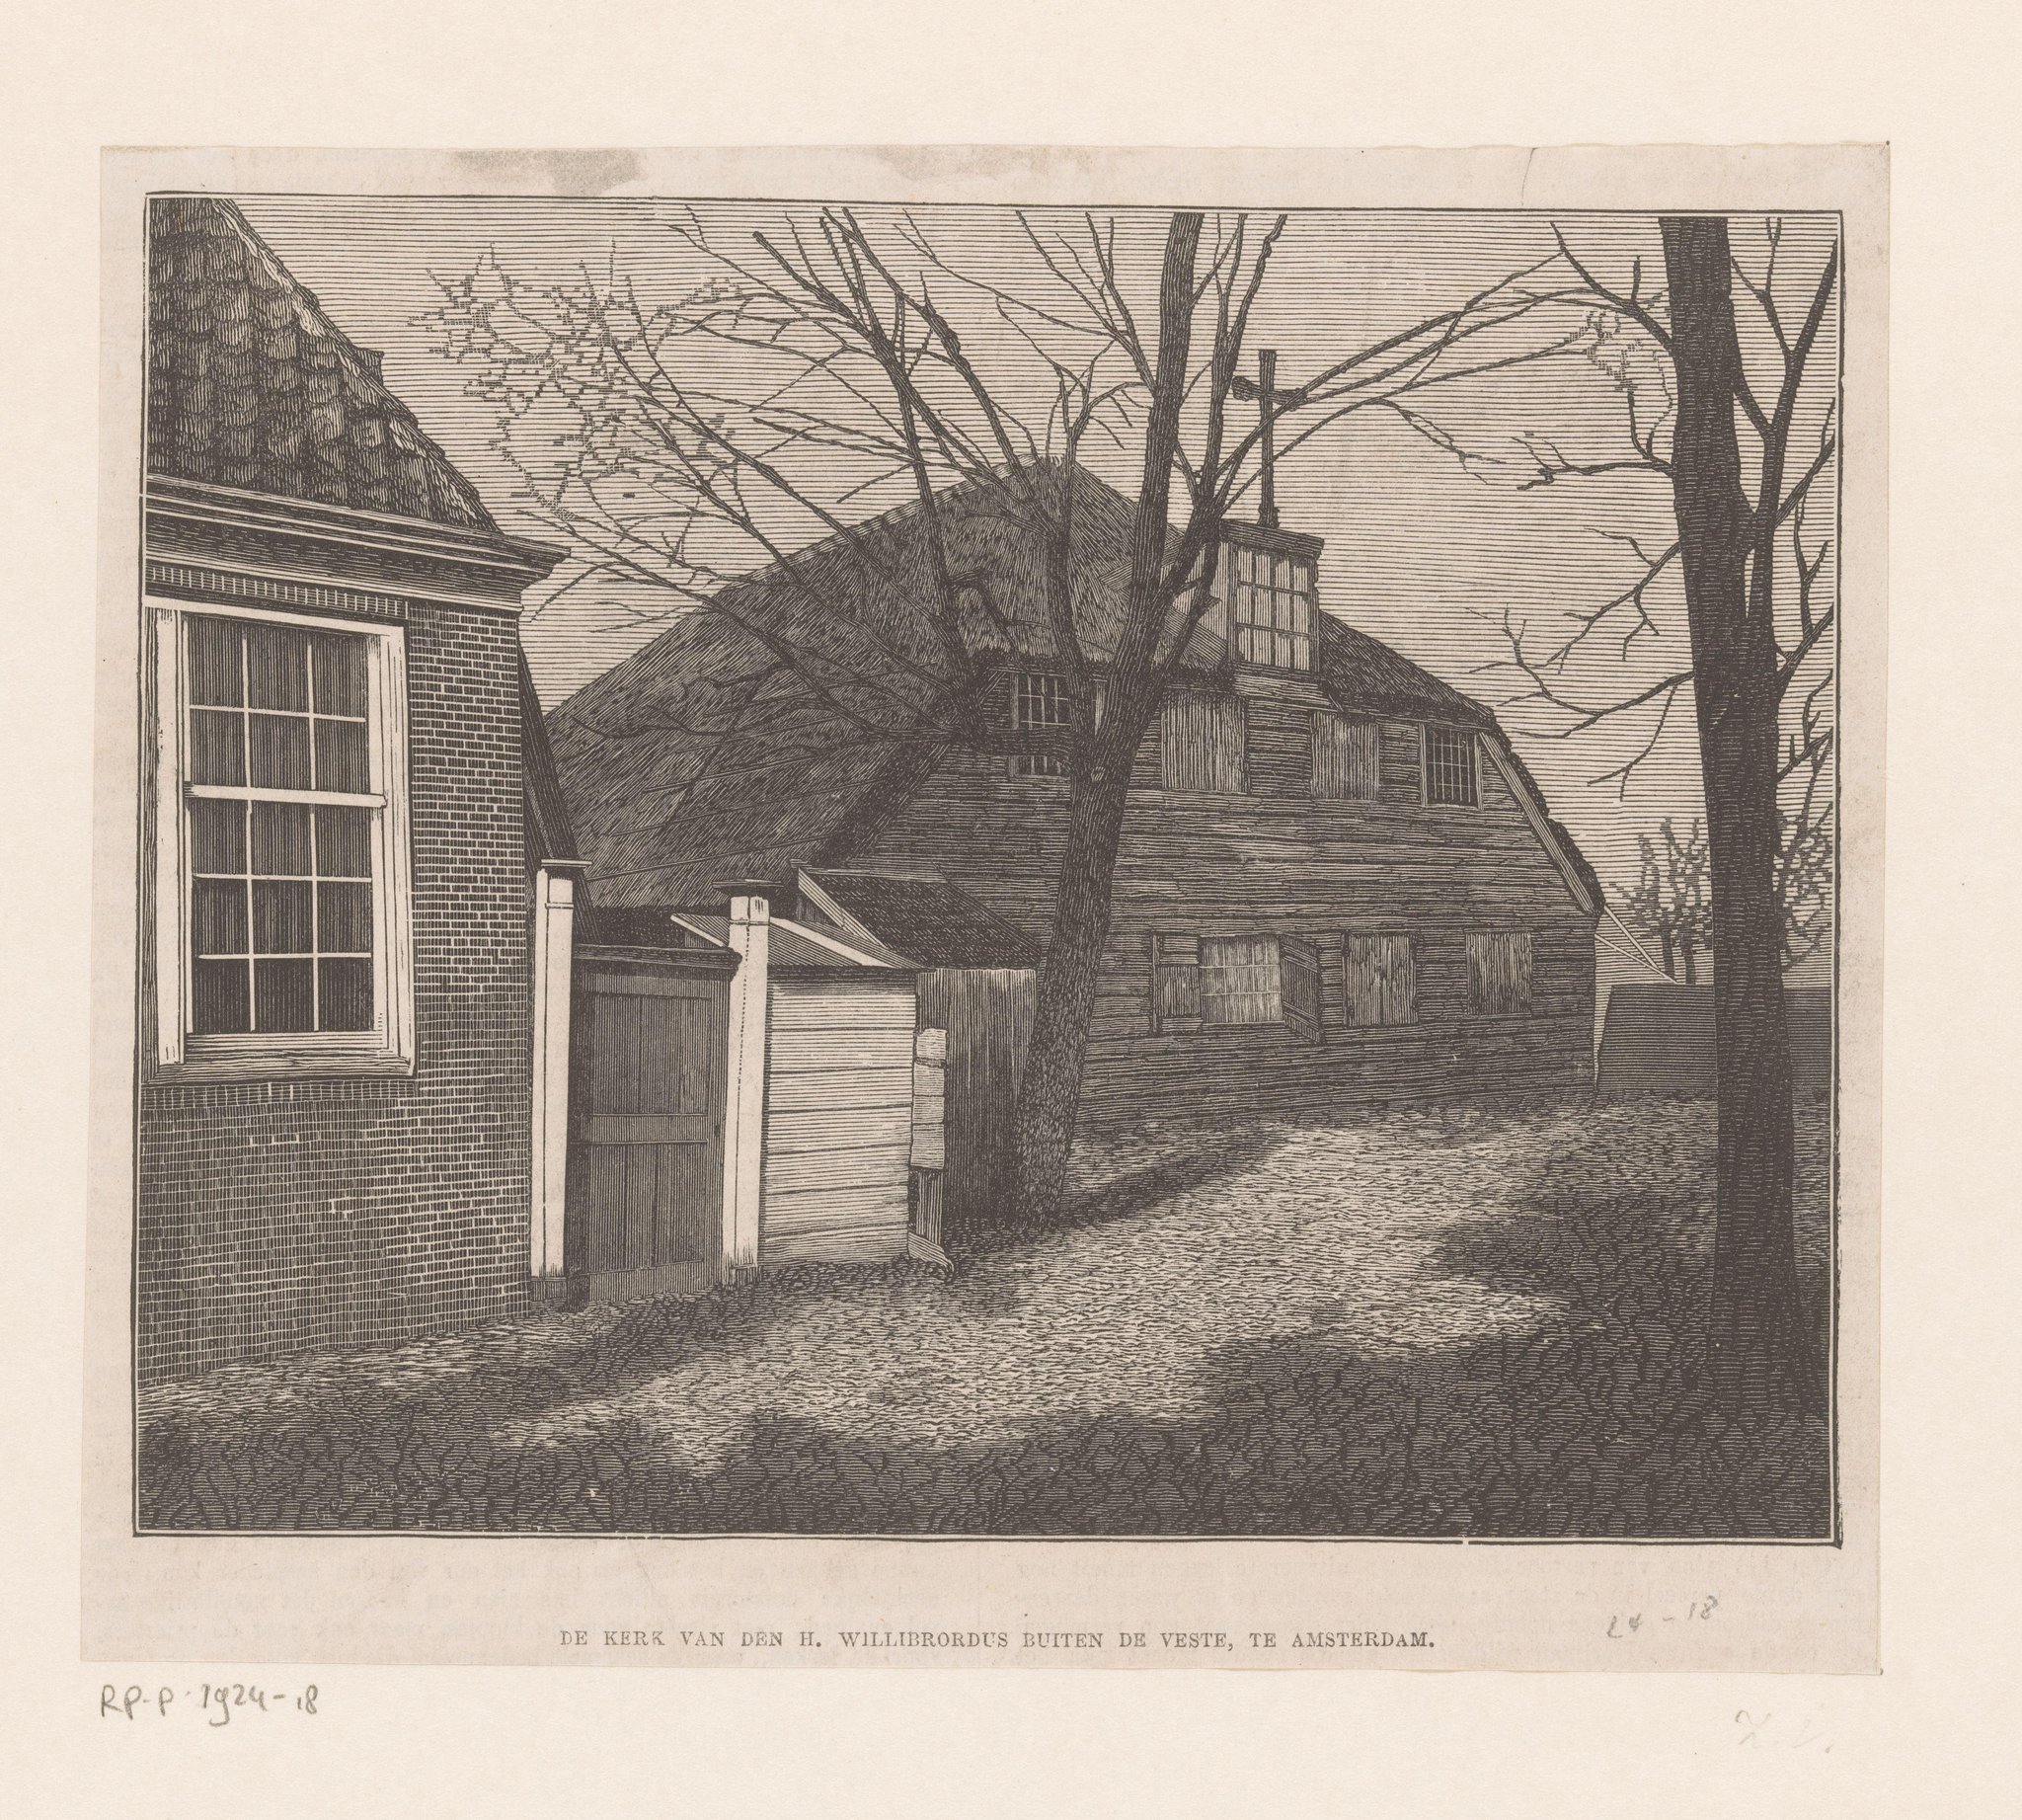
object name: book illustration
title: De kerk van den H. Willibrordus buiten de Veste, te Amsterdam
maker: Anonymous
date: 1875-1924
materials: paper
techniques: letterpress printing, engraving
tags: church (exterior), amsterdam